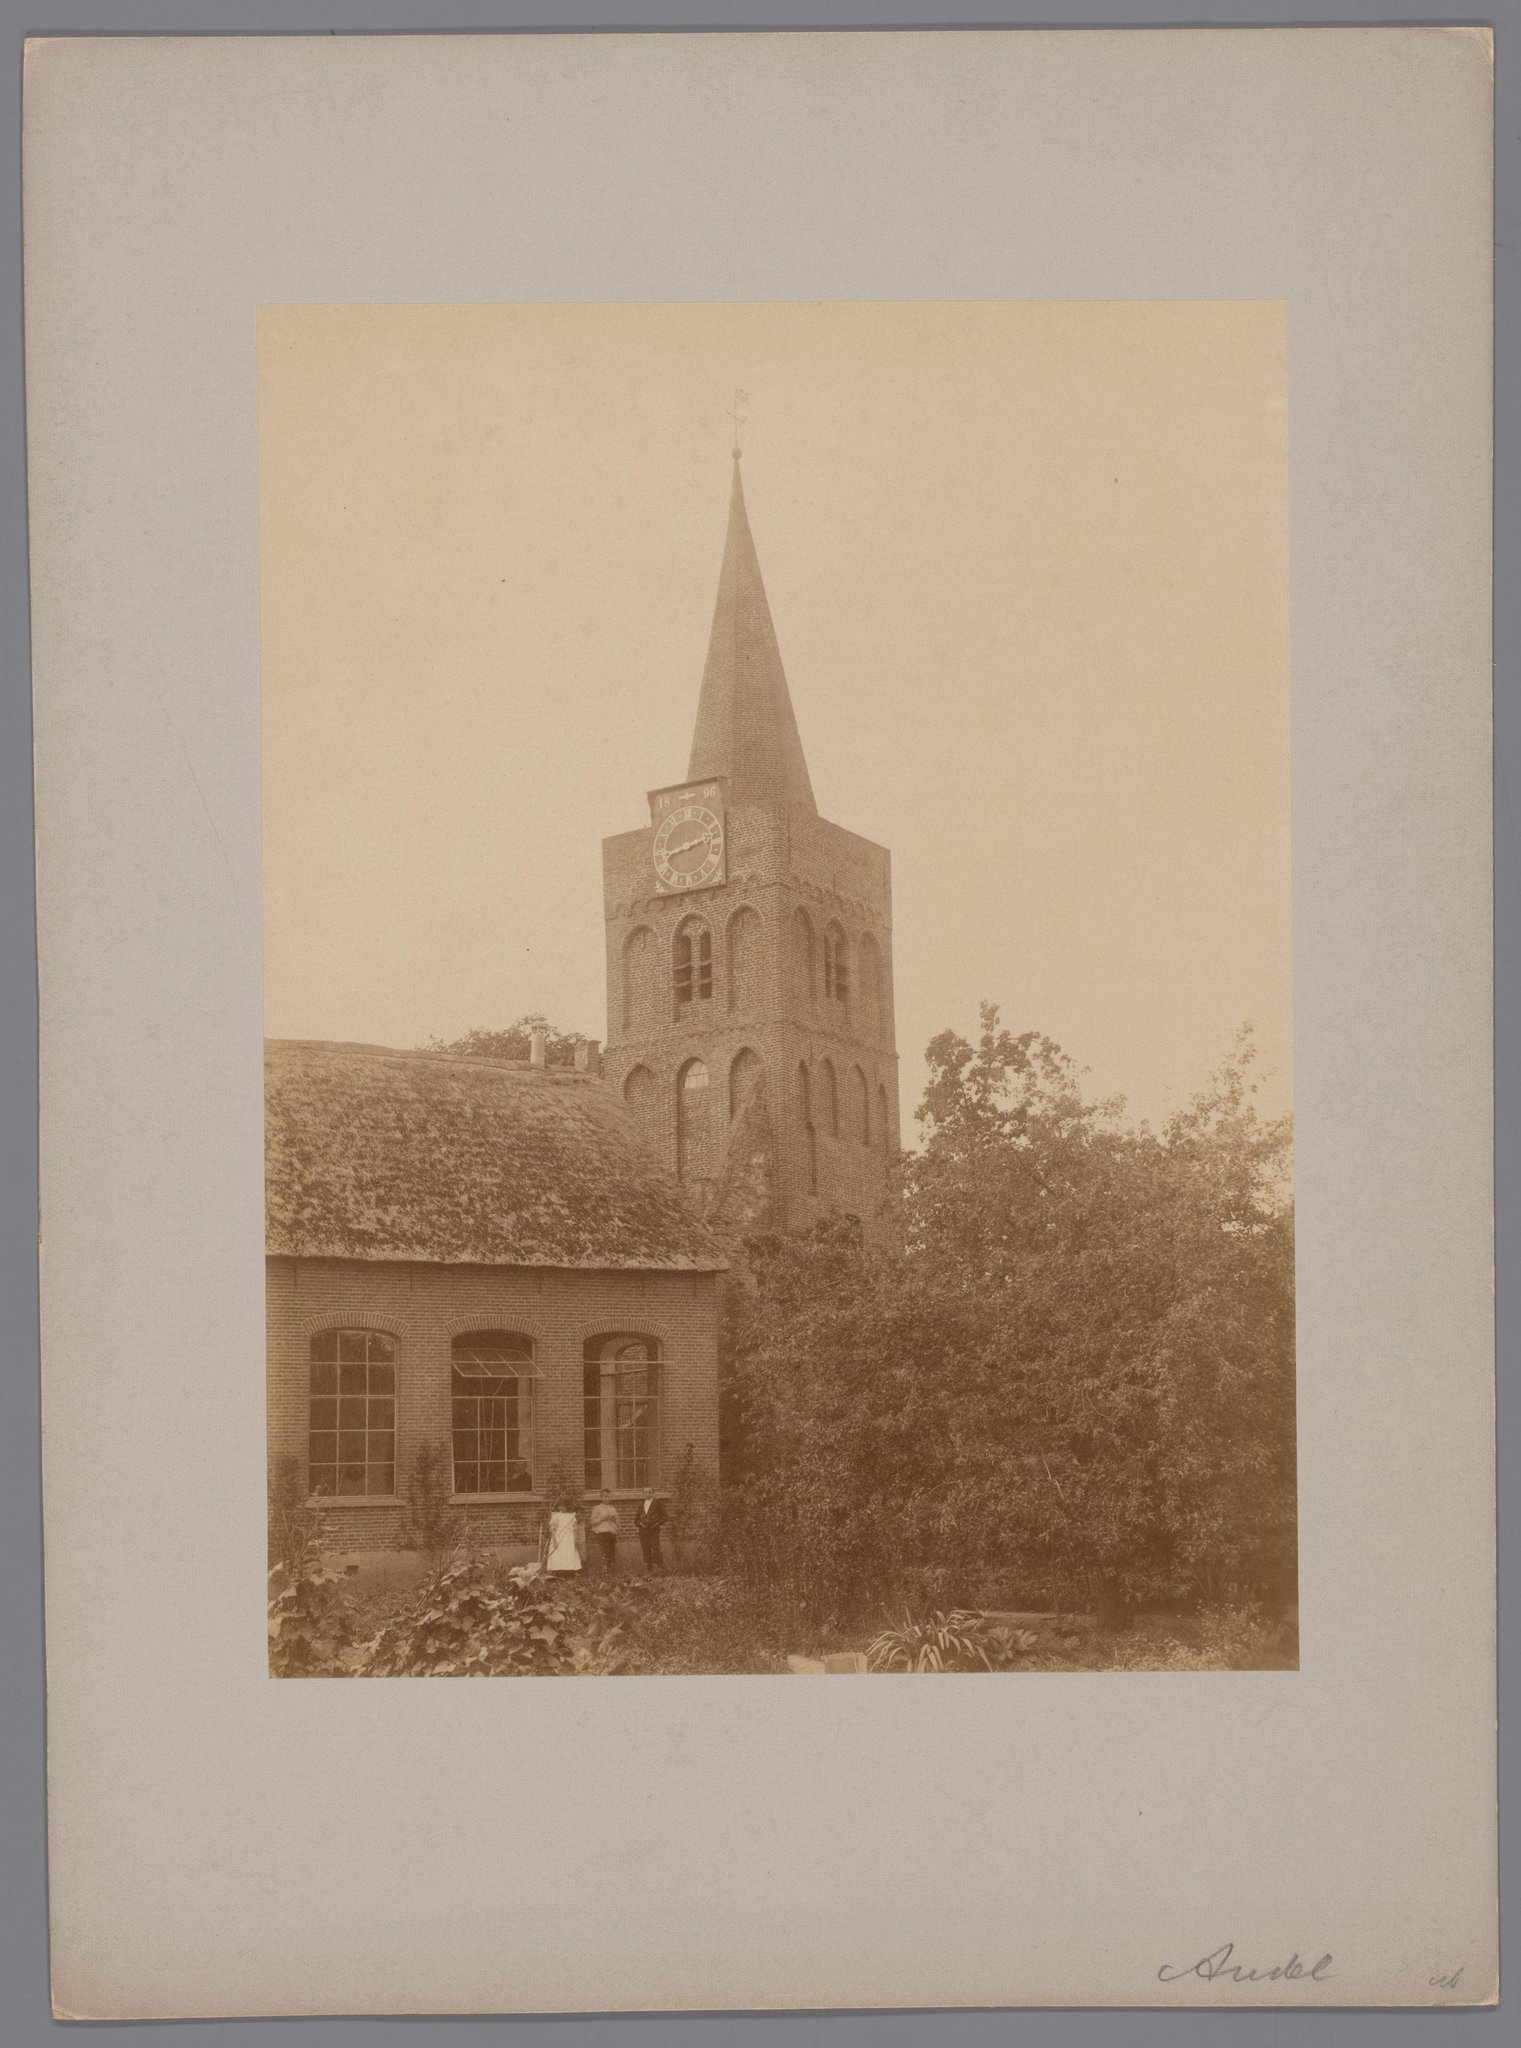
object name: photograph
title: Gezicht op de Romboutstoren te Andel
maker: anoniem (monumentenzorg)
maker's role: fotograaf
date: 1897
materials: cardboard, photographic support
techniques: albumen print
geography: andel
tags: parts of church exterior and annexes: tower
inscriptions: annotation: ‘Toren te Andel a/d Maas (N.B.)/ Aug 1897’, annotation: ‘Andel’